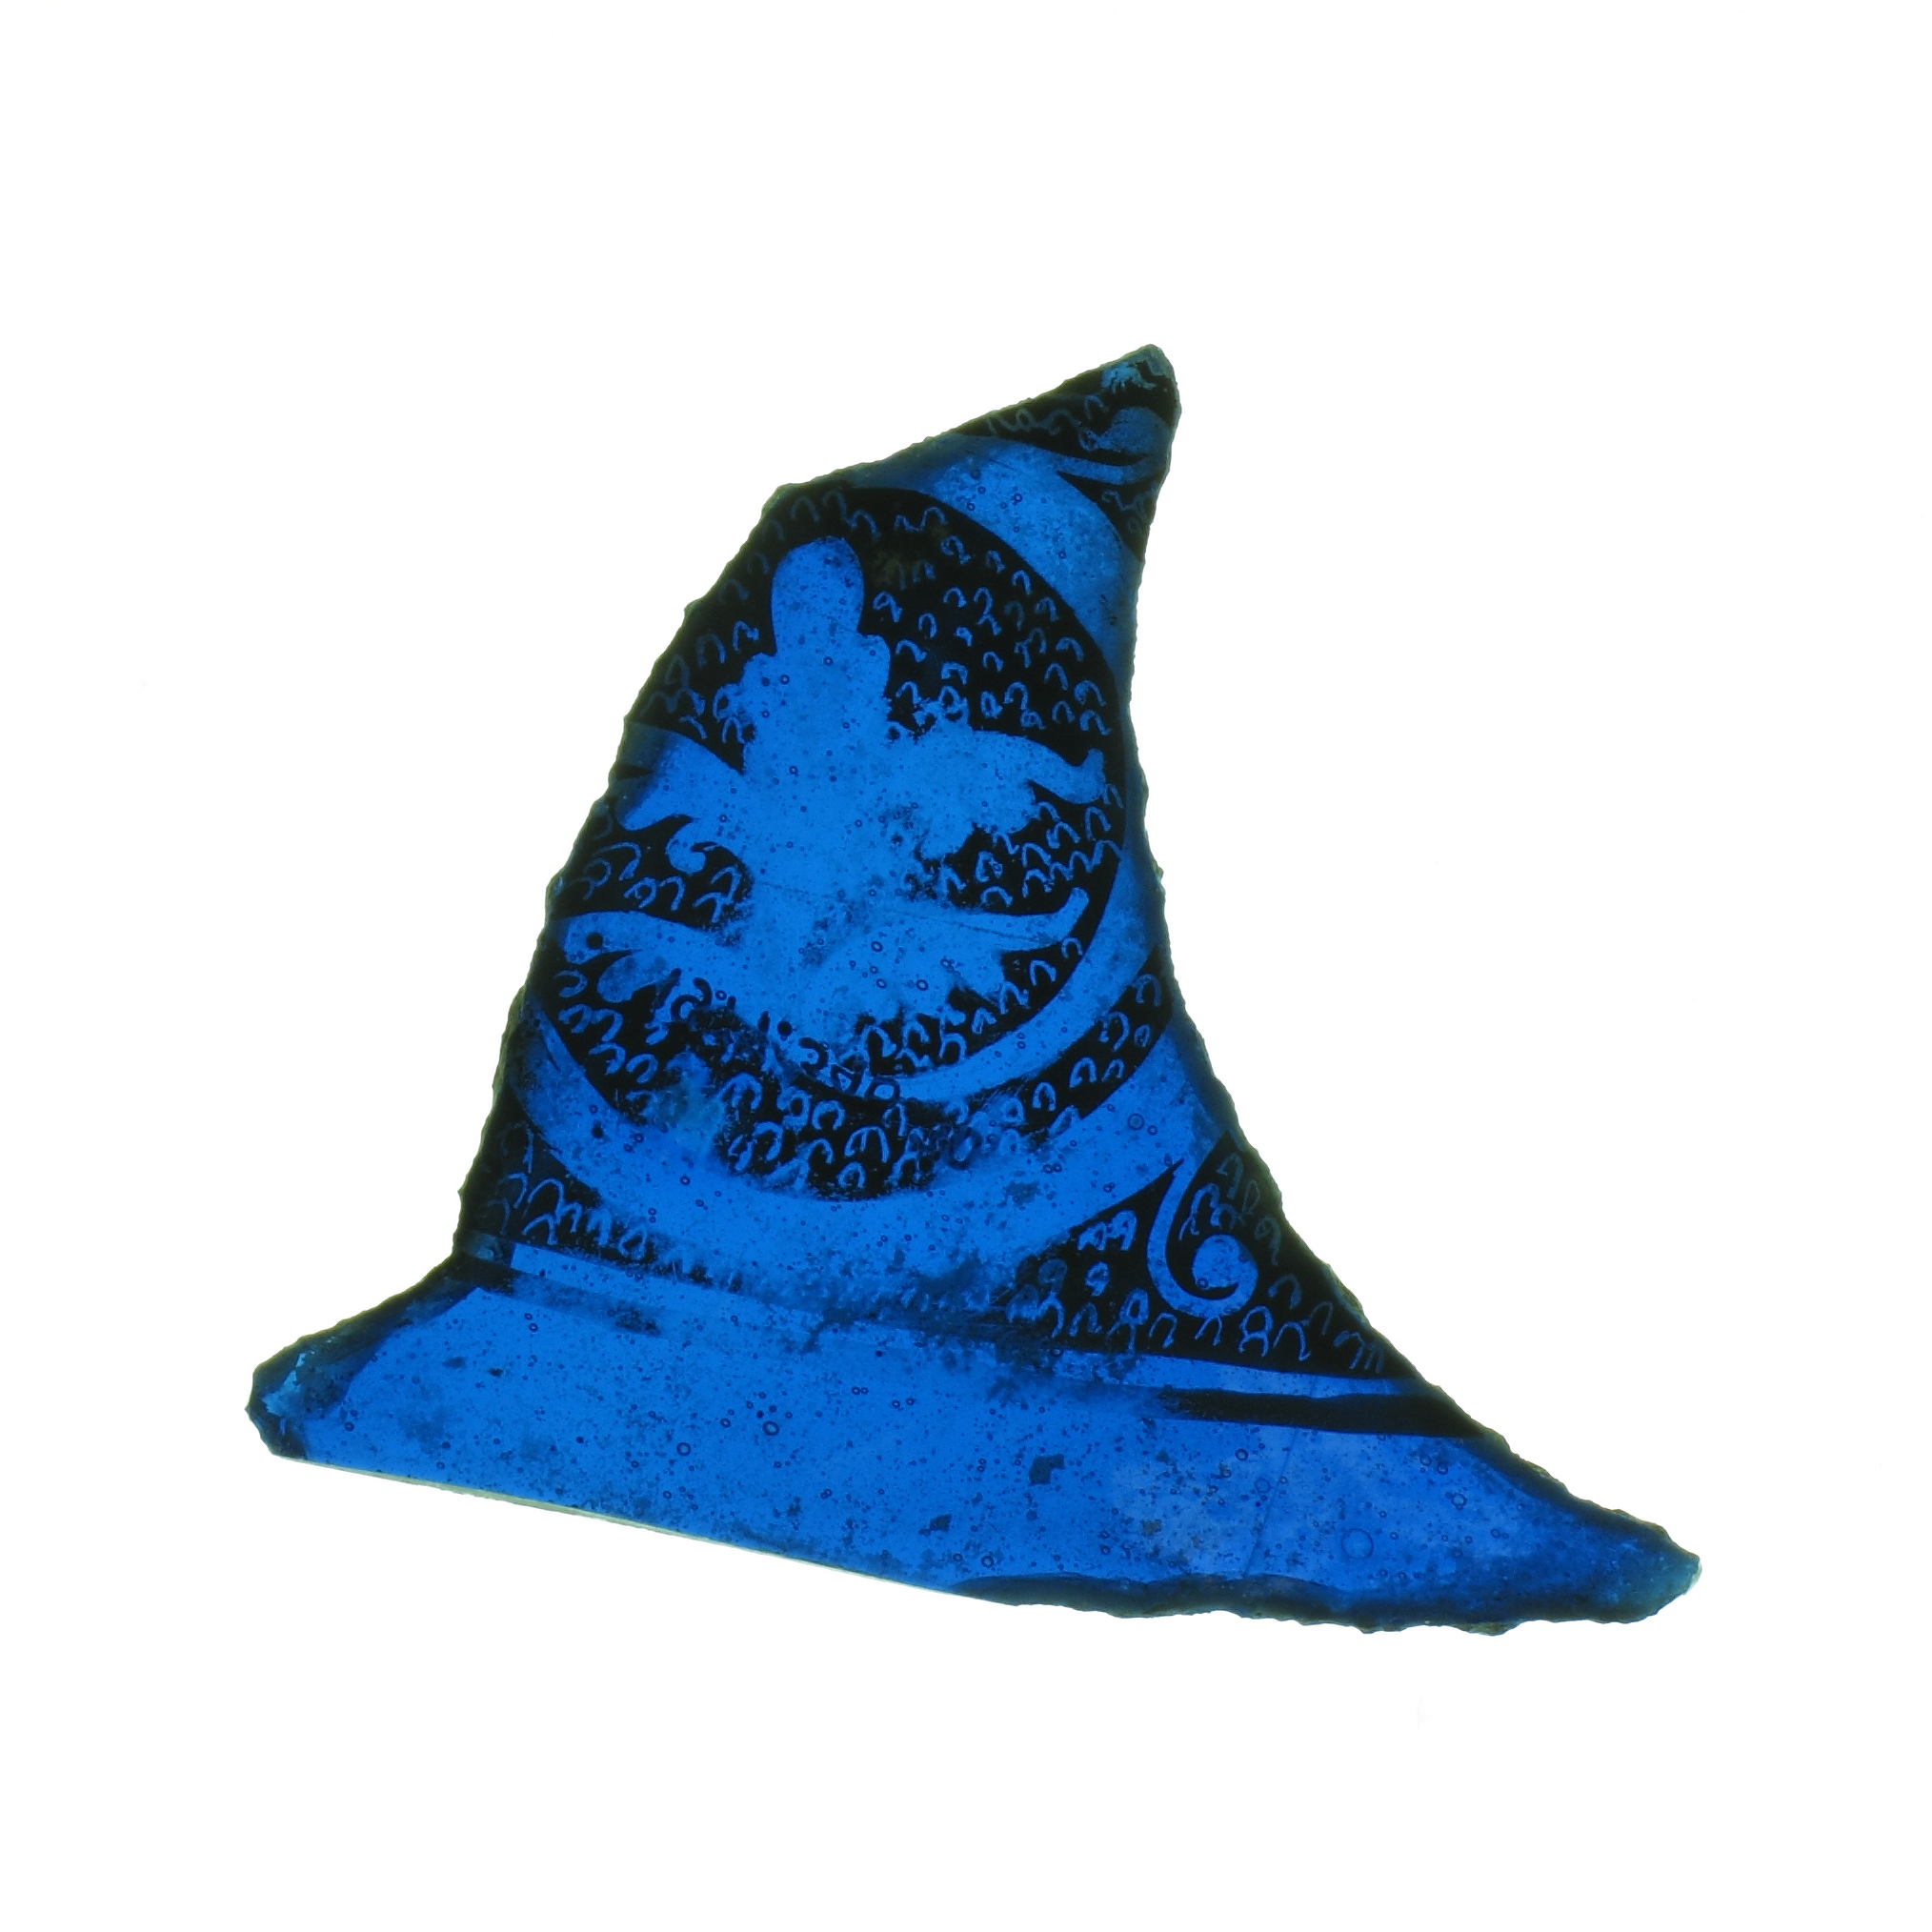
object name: fragment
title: Glass Fragment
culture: french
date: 1101-1400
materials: glass, metal, paint